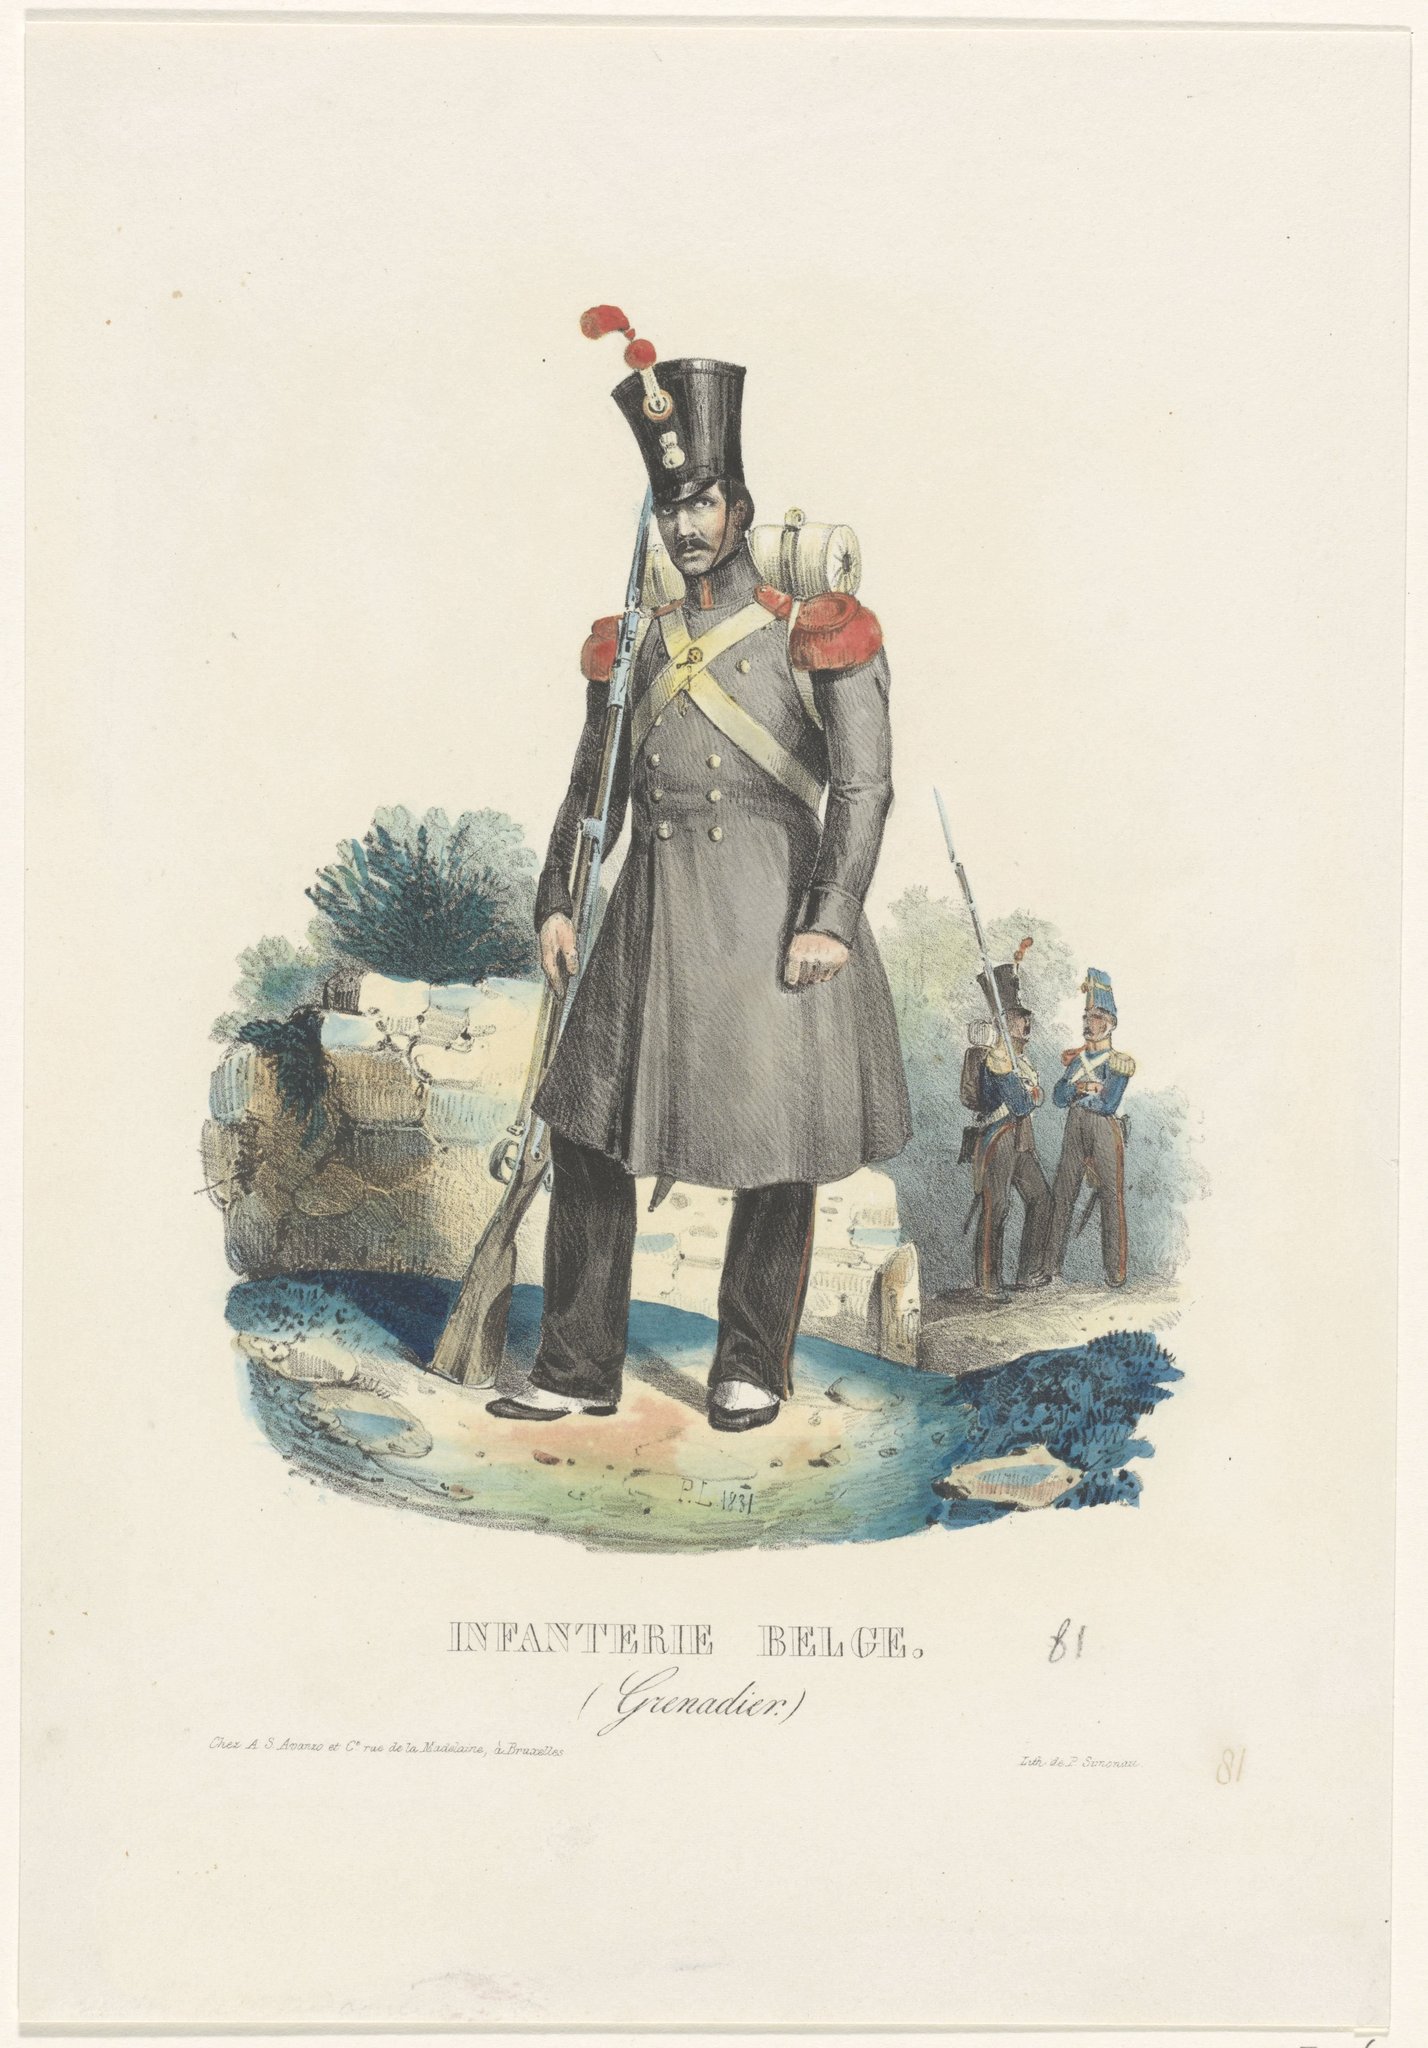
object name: costume print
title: Belgische grenadier, 1831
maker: Anonymous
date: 1831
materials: paper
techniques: hand coloring, lithograph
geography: brussels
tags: (military) uniforms, clothes, costume, belgium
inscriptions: collector's mark: Lugt 2228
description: Een grenadier van de Belgische infanterie, 1831. Onderdeel van een groep voorstellingen van Belgische uniformen.